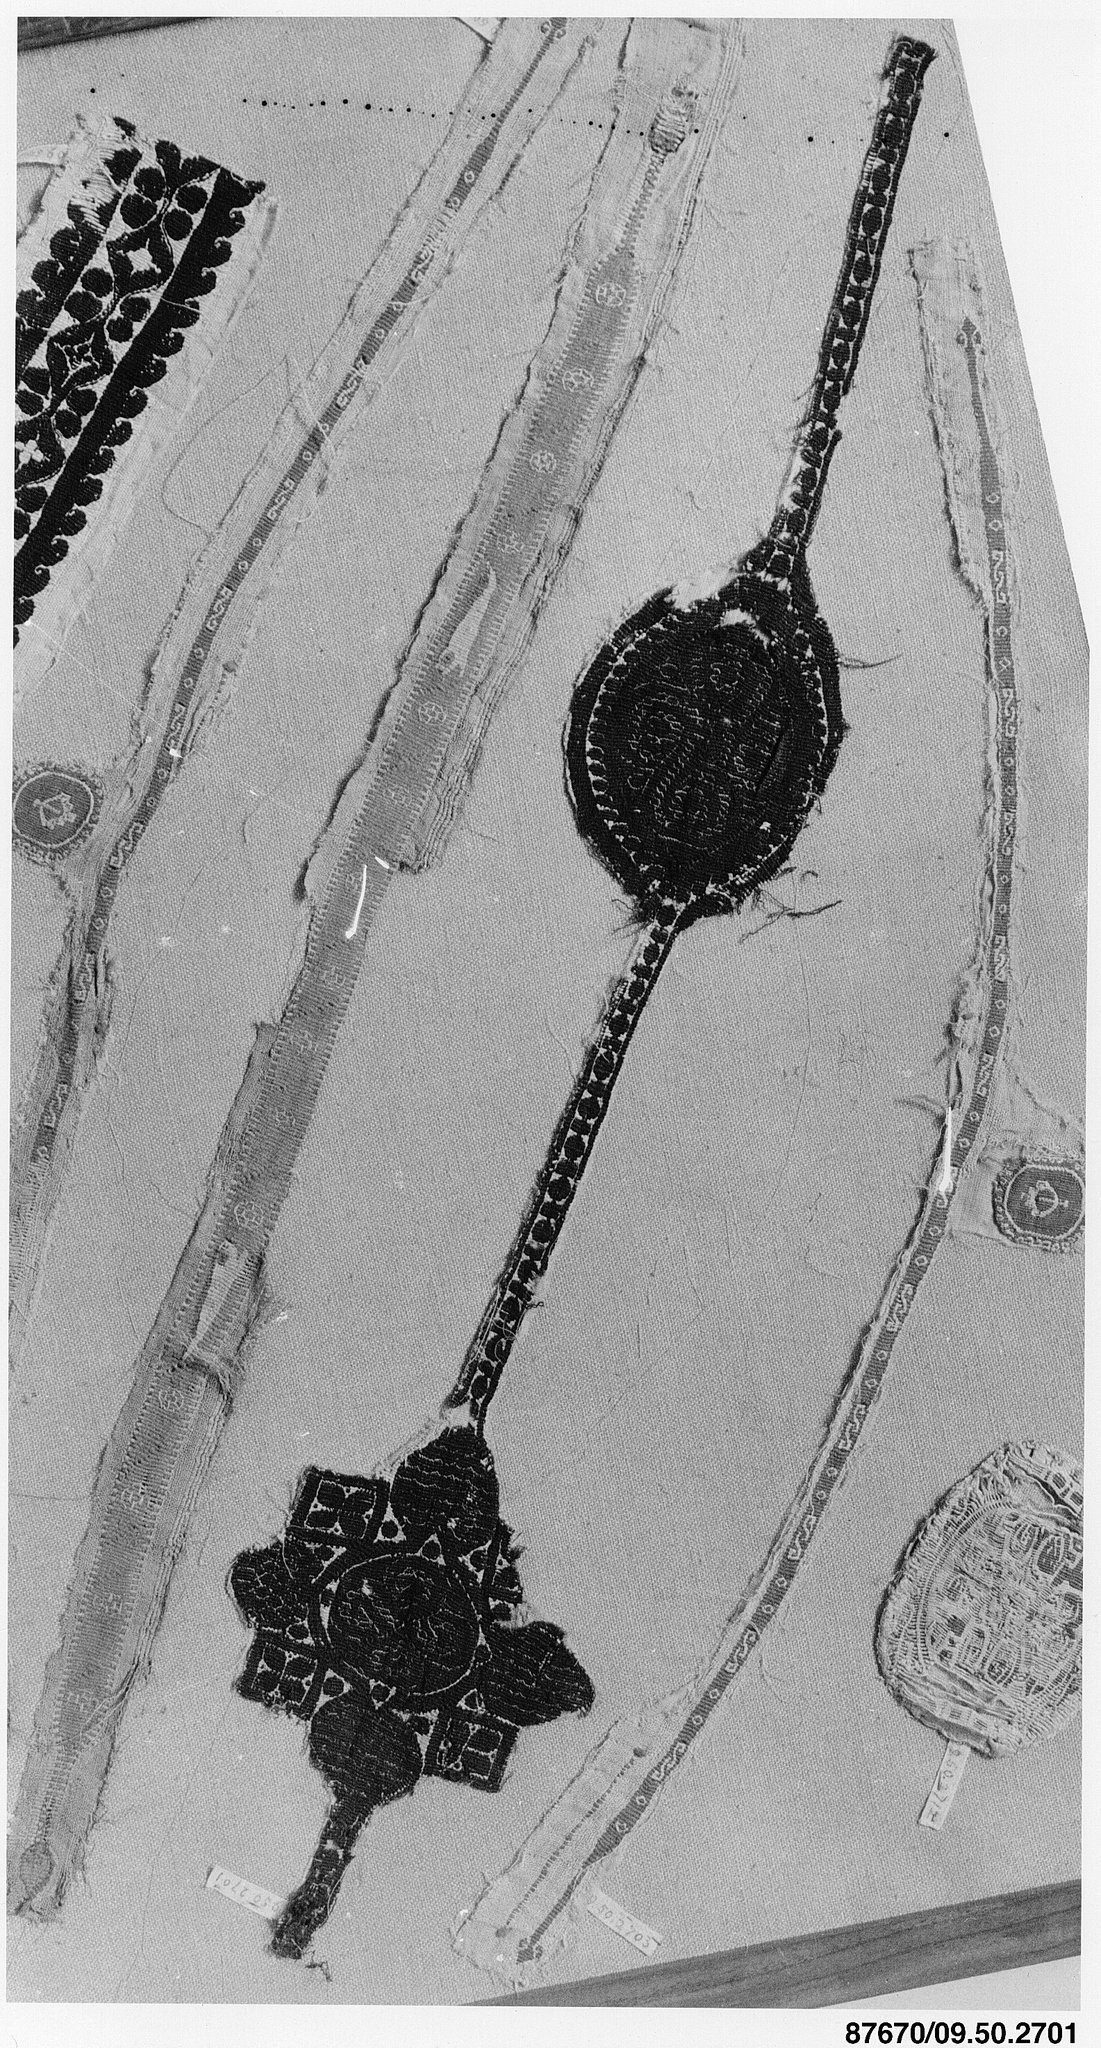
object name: panel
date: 301-500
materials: linen, wool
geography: egypt